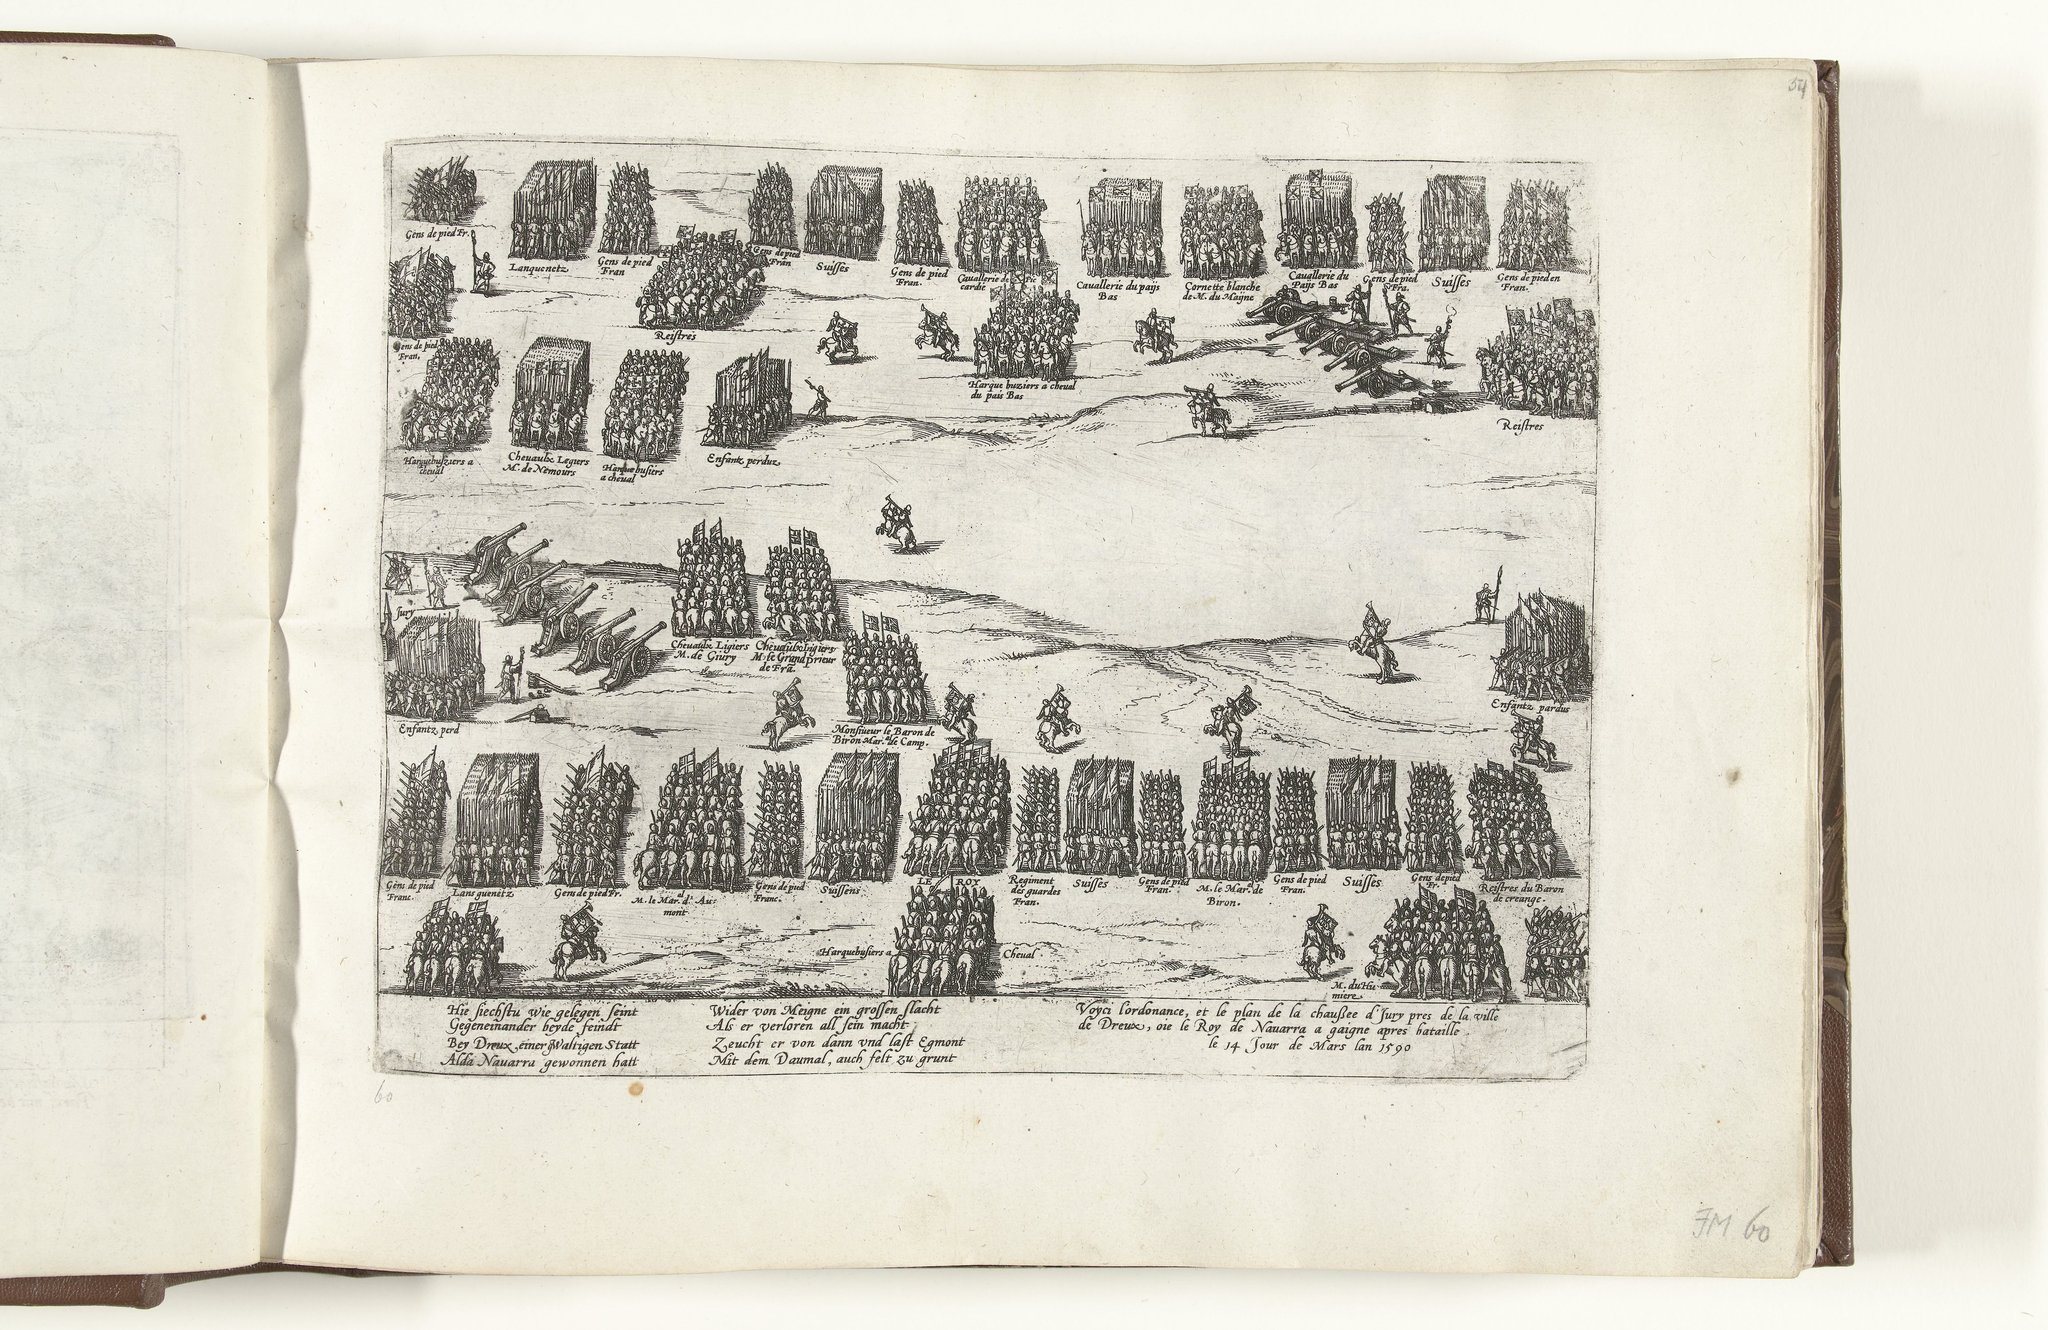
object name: print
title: Serie 4: Franse, Duitse en Engelse Gebeurtenissen, 1576-1610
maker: frans hogenberg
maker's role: print maker, publisher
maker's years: 1538-1590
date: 1590-1612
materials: paper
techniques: etching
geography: cologne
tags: paris, hendrik iv (koning van frankrijk en navarra), preparation for battle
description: Slagorde van de opgestelde legers bij Dreux, voorafgaand aan de slag bij Ivry, 14 maart 1590. Met onderschrift van 8 regels in het Duits en 2 regels in het Frans. Ongenummerd.